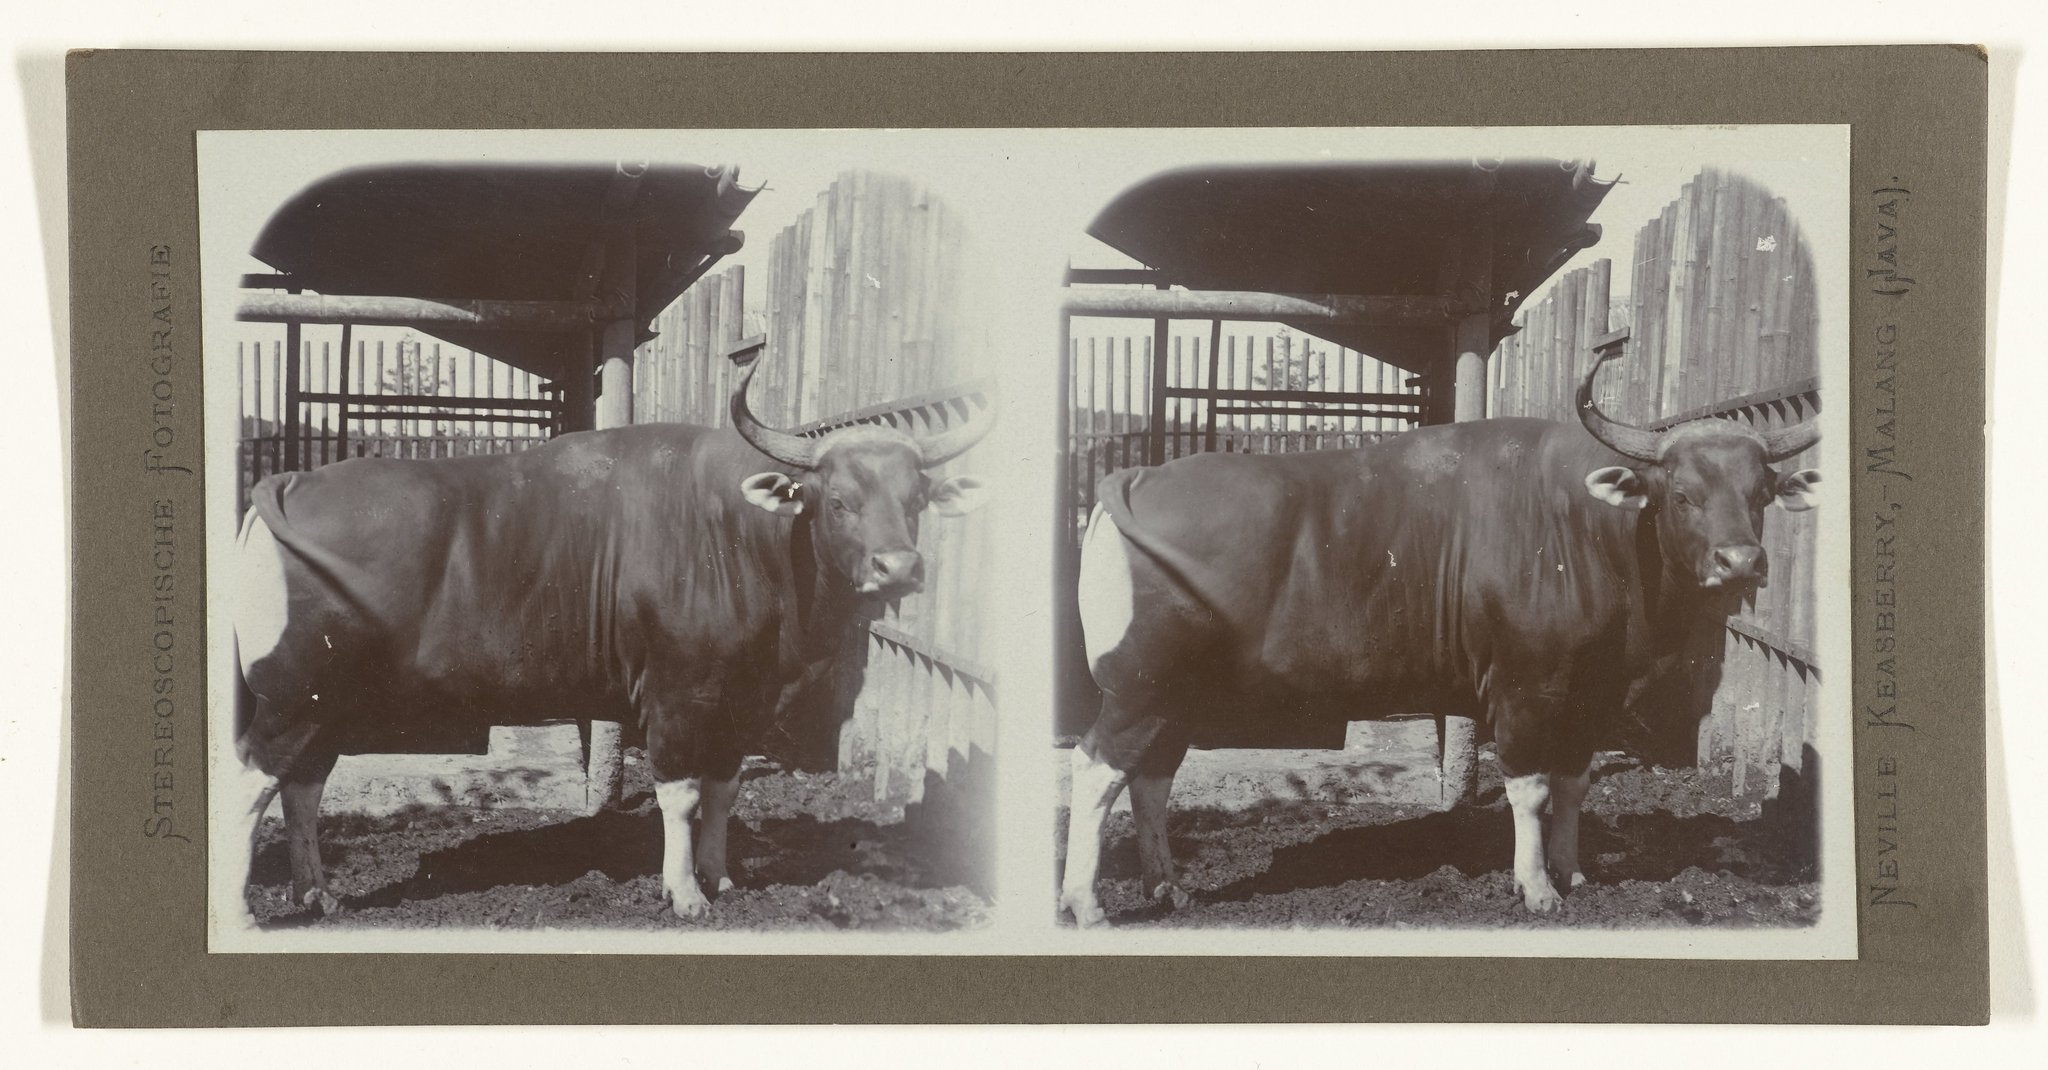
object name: photograph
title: S 8 No 96. De Banteng van Kali-Tapah. Eigr Mr. Alberts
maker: neville keasberry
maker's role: fotograaf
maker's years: 1866-1944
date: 1900-1935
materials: cardboard, paper, photographic support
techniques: albumen print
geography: malang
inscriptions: inscription: ‘Stereoscopische Fotografie’, signature: ‘Neville Keasberry, Malang (Java)’